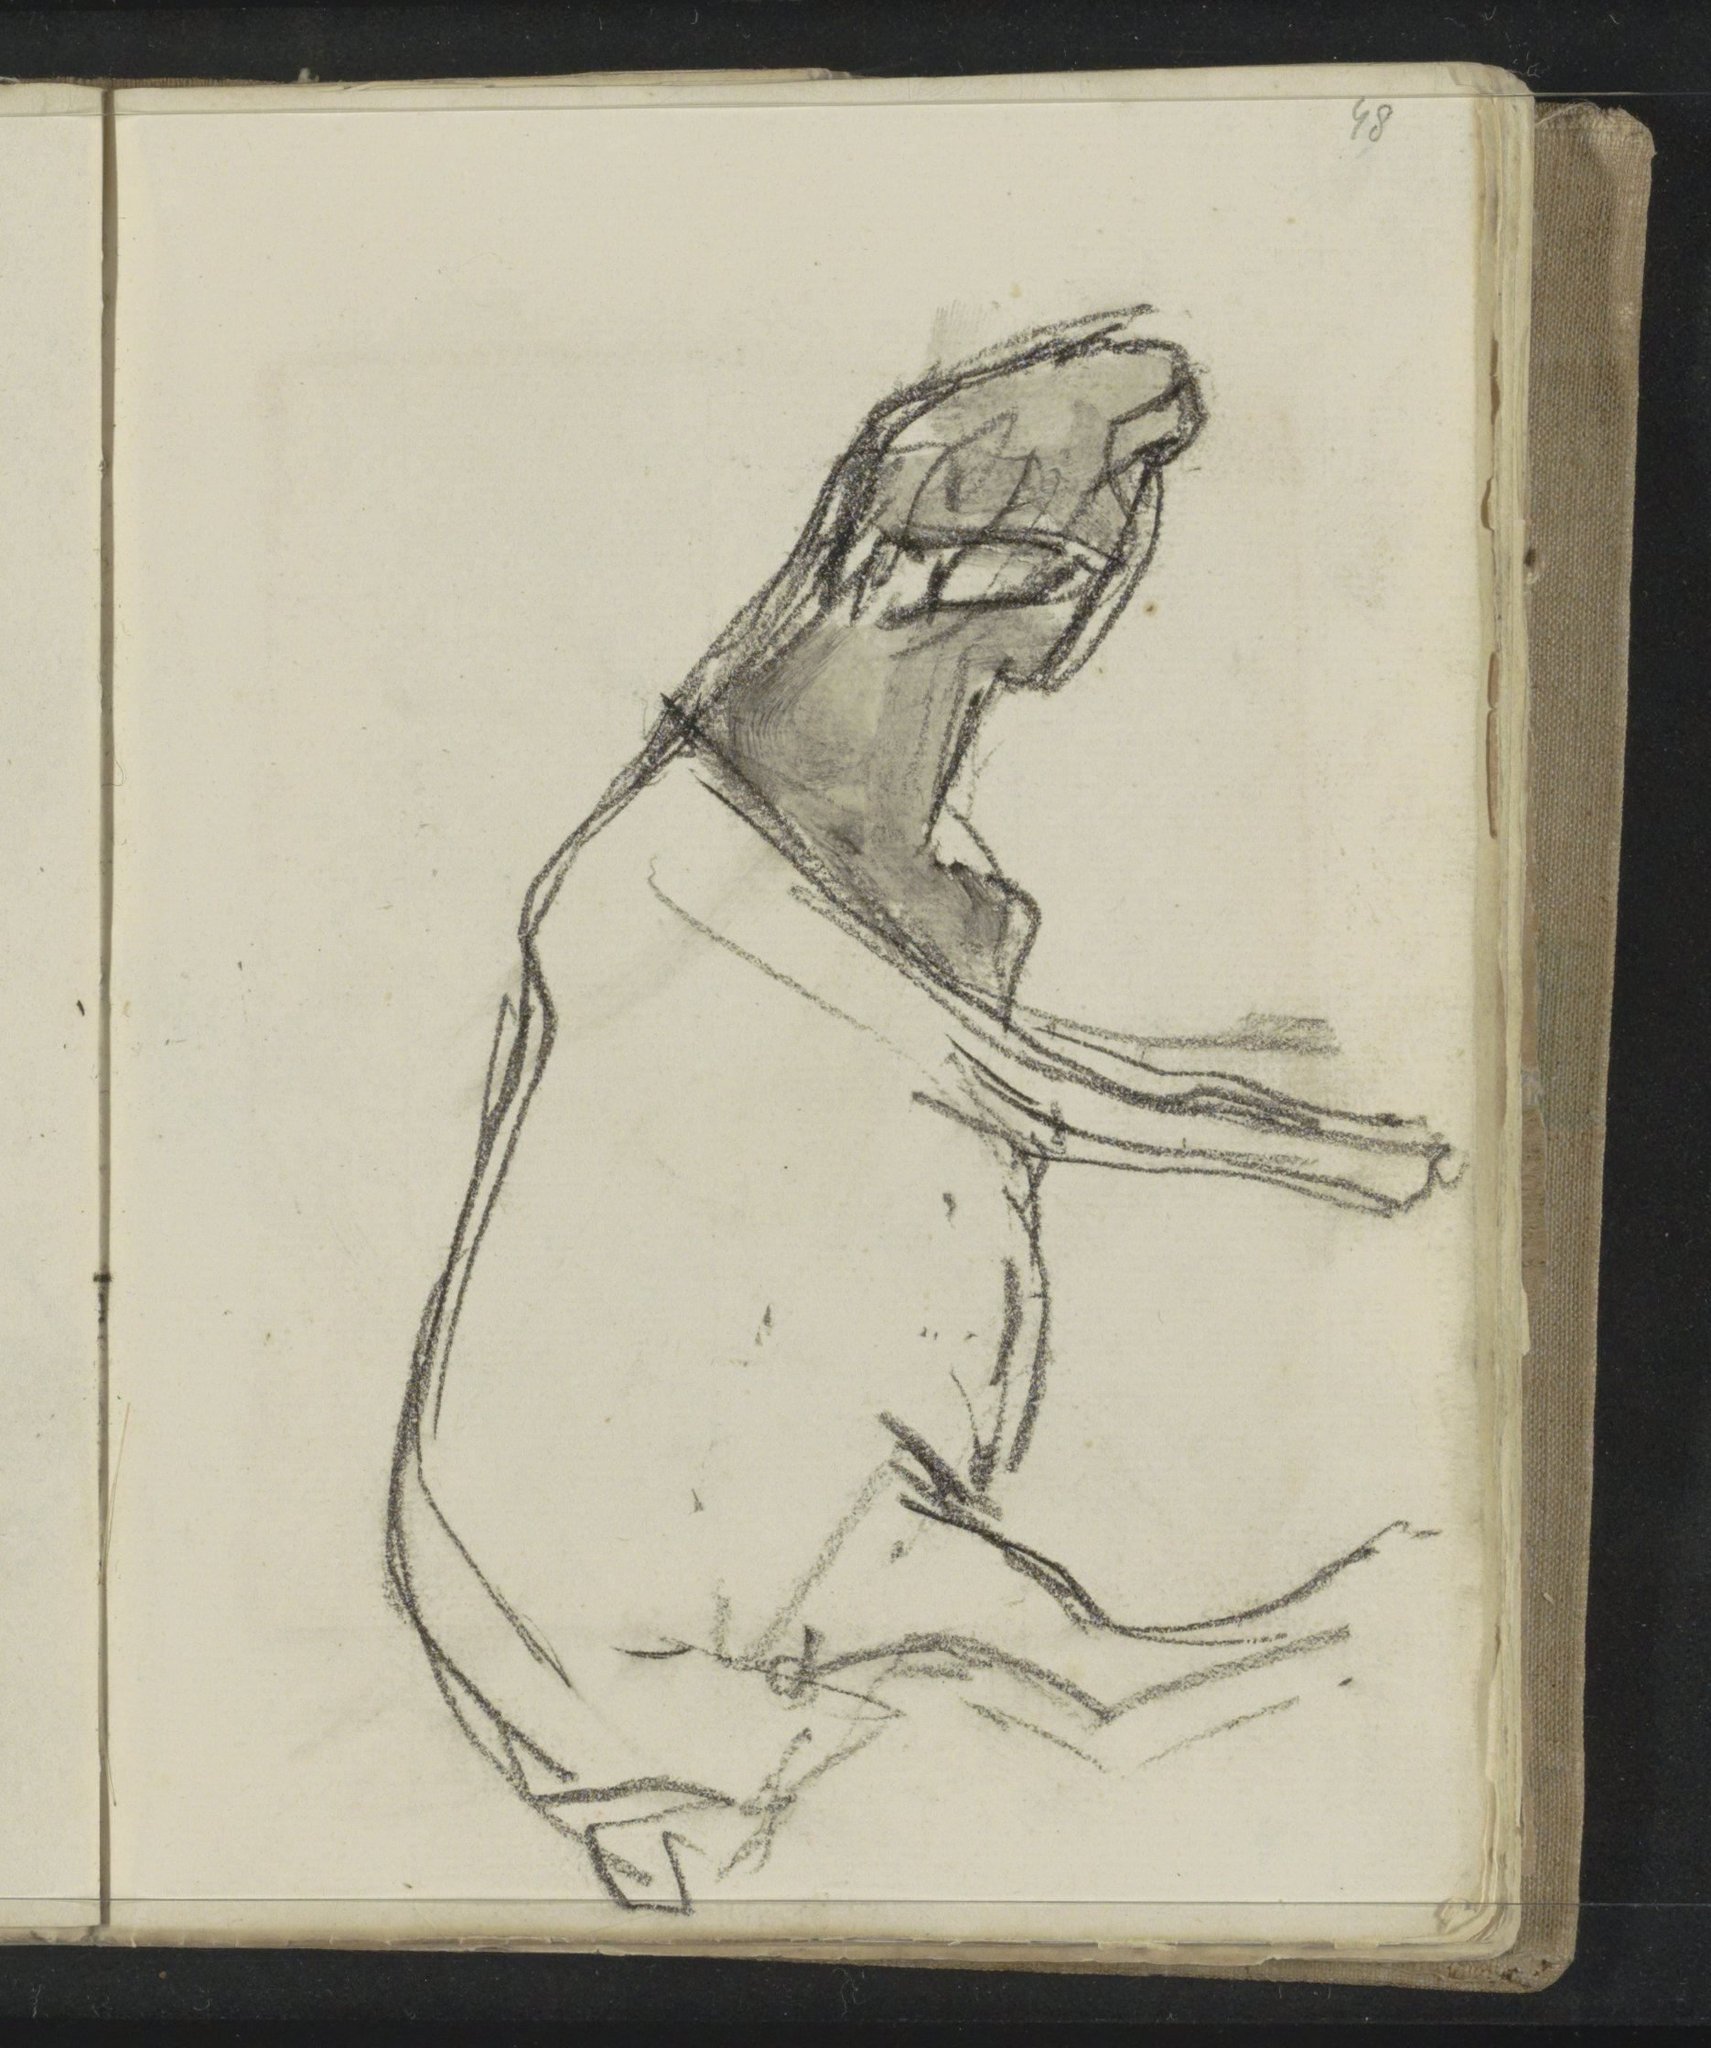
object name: sketchbook leaf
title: Schaap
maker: floris arntzenius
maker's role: draughtsman, print maker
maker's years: 1864-1925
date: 1883-1914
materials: chalk, paper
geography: the hague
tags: sheep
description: Pagina 48 uit een schetsboek met 82 pagina's.